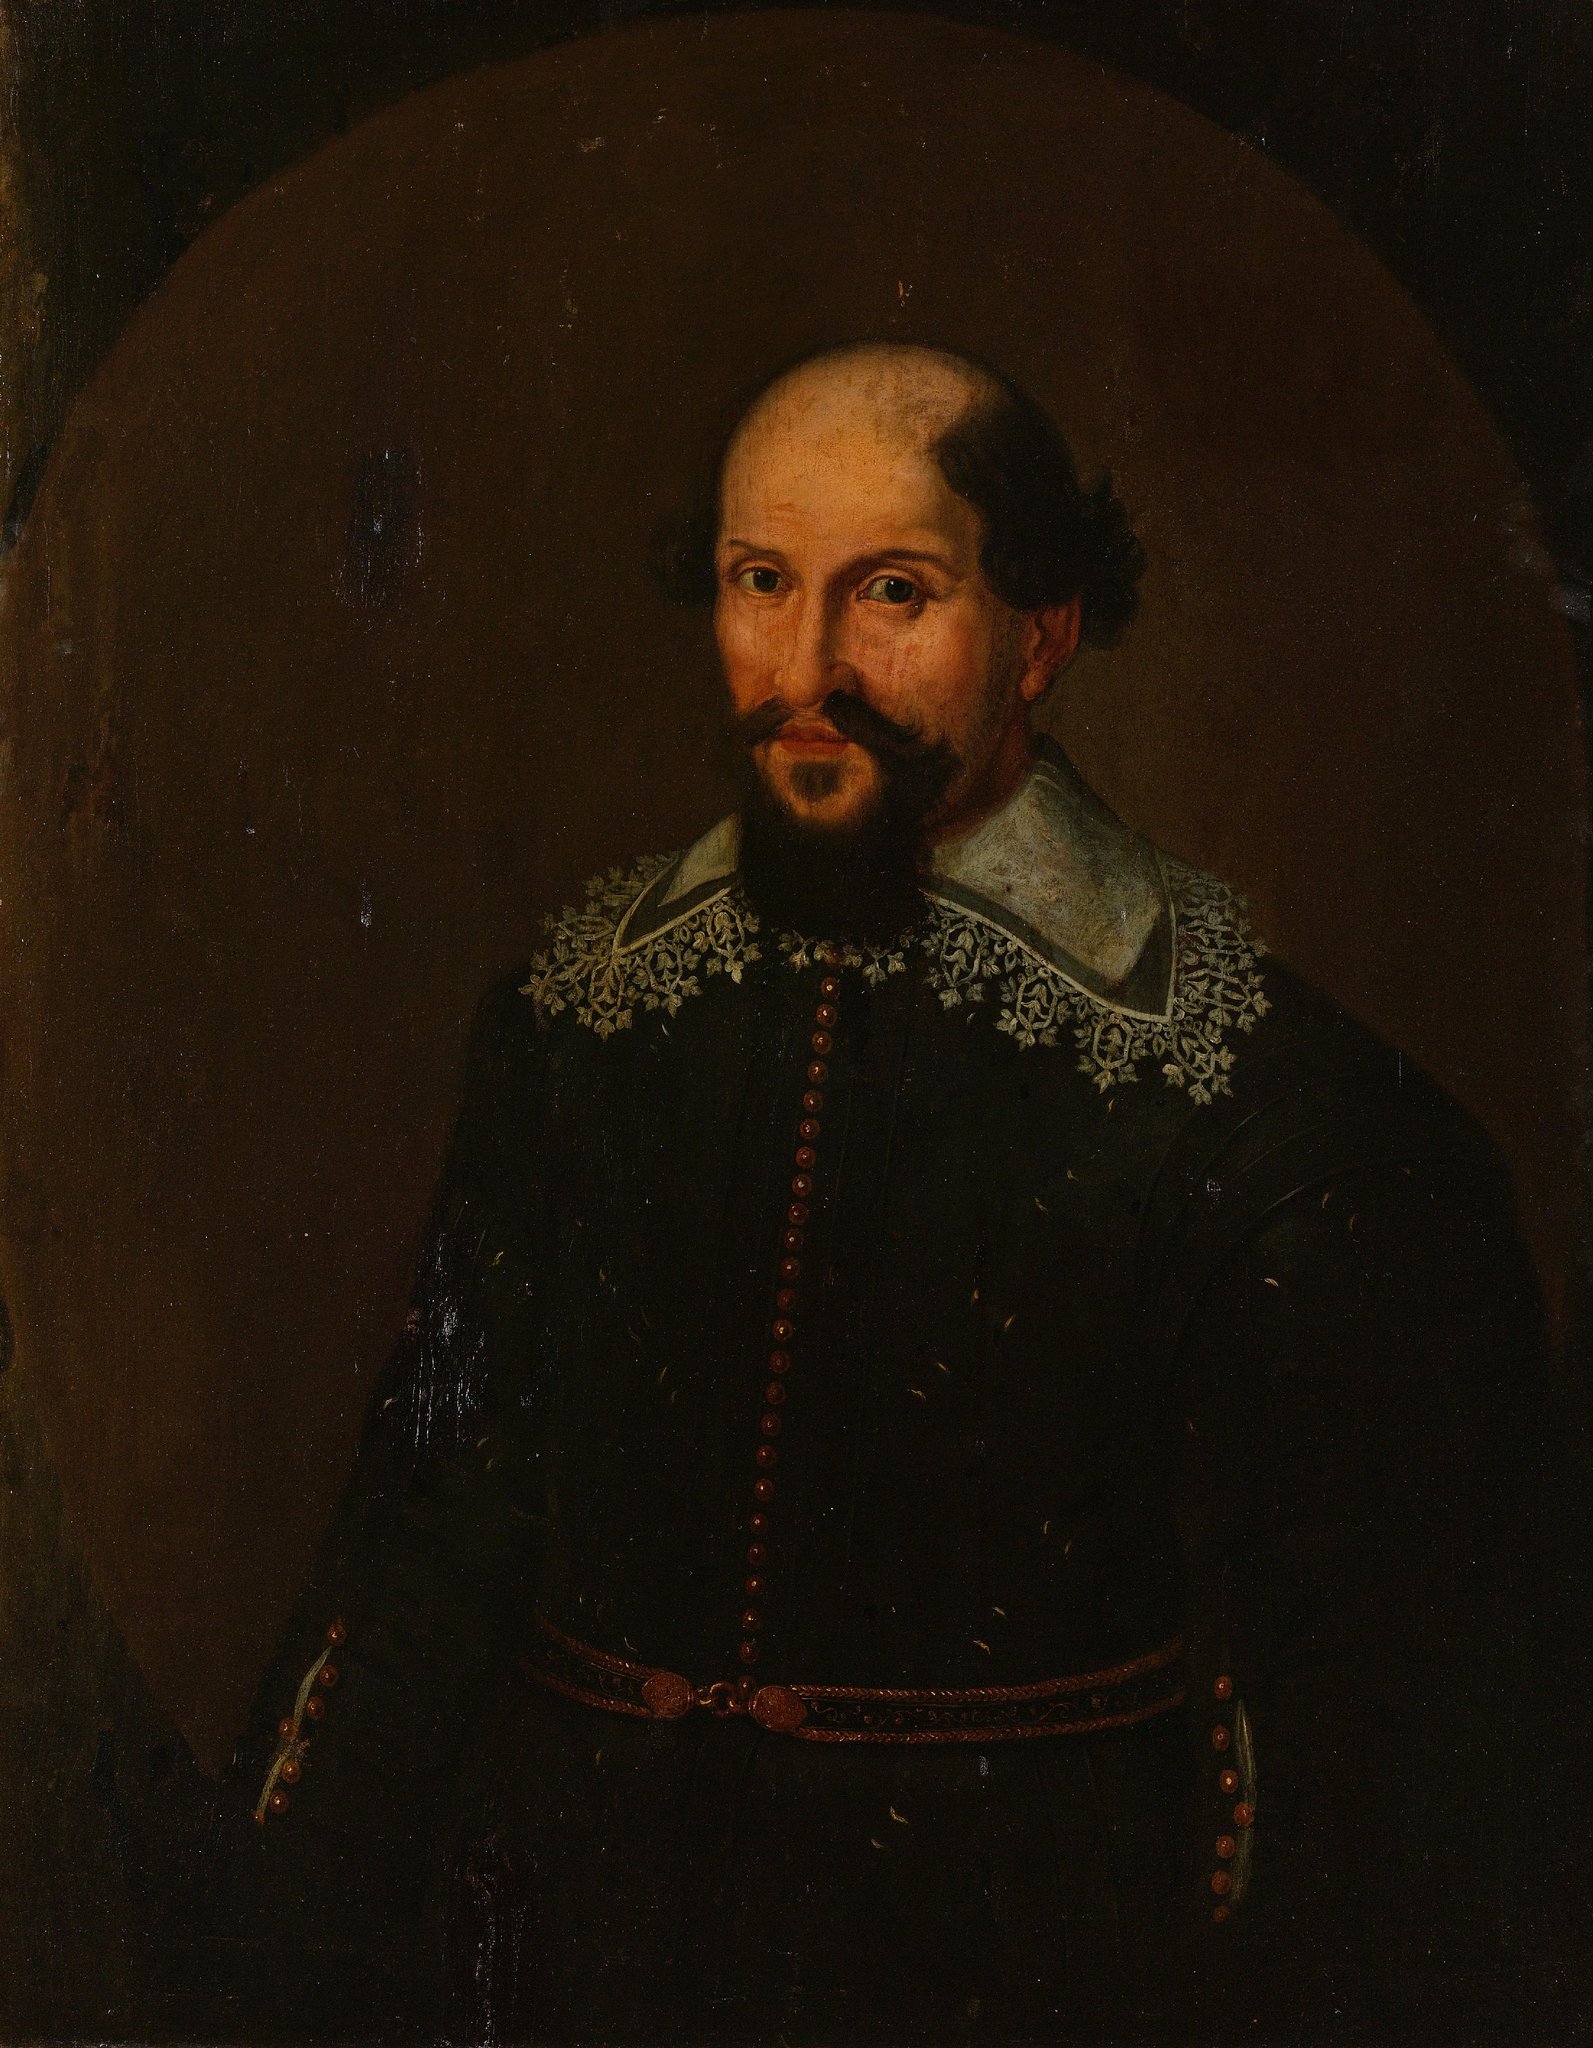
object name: painting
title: Portrait of Jacques Specx, Governor-General of the Dutch East Indies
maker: Anonymous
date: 1629-1675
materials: oil, panel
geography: netherlands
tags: colonial governor, historical persons, dutch east indies, the, japan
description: Portret van Jacques Specx (geb. 1588). Gouverneur-generaal (1629-32). Ten halven lijve, naar links. Onderdeel van een reeks van portretten van de gouverneurs-generaal van het voormalige Nederlands Oost-Indië.